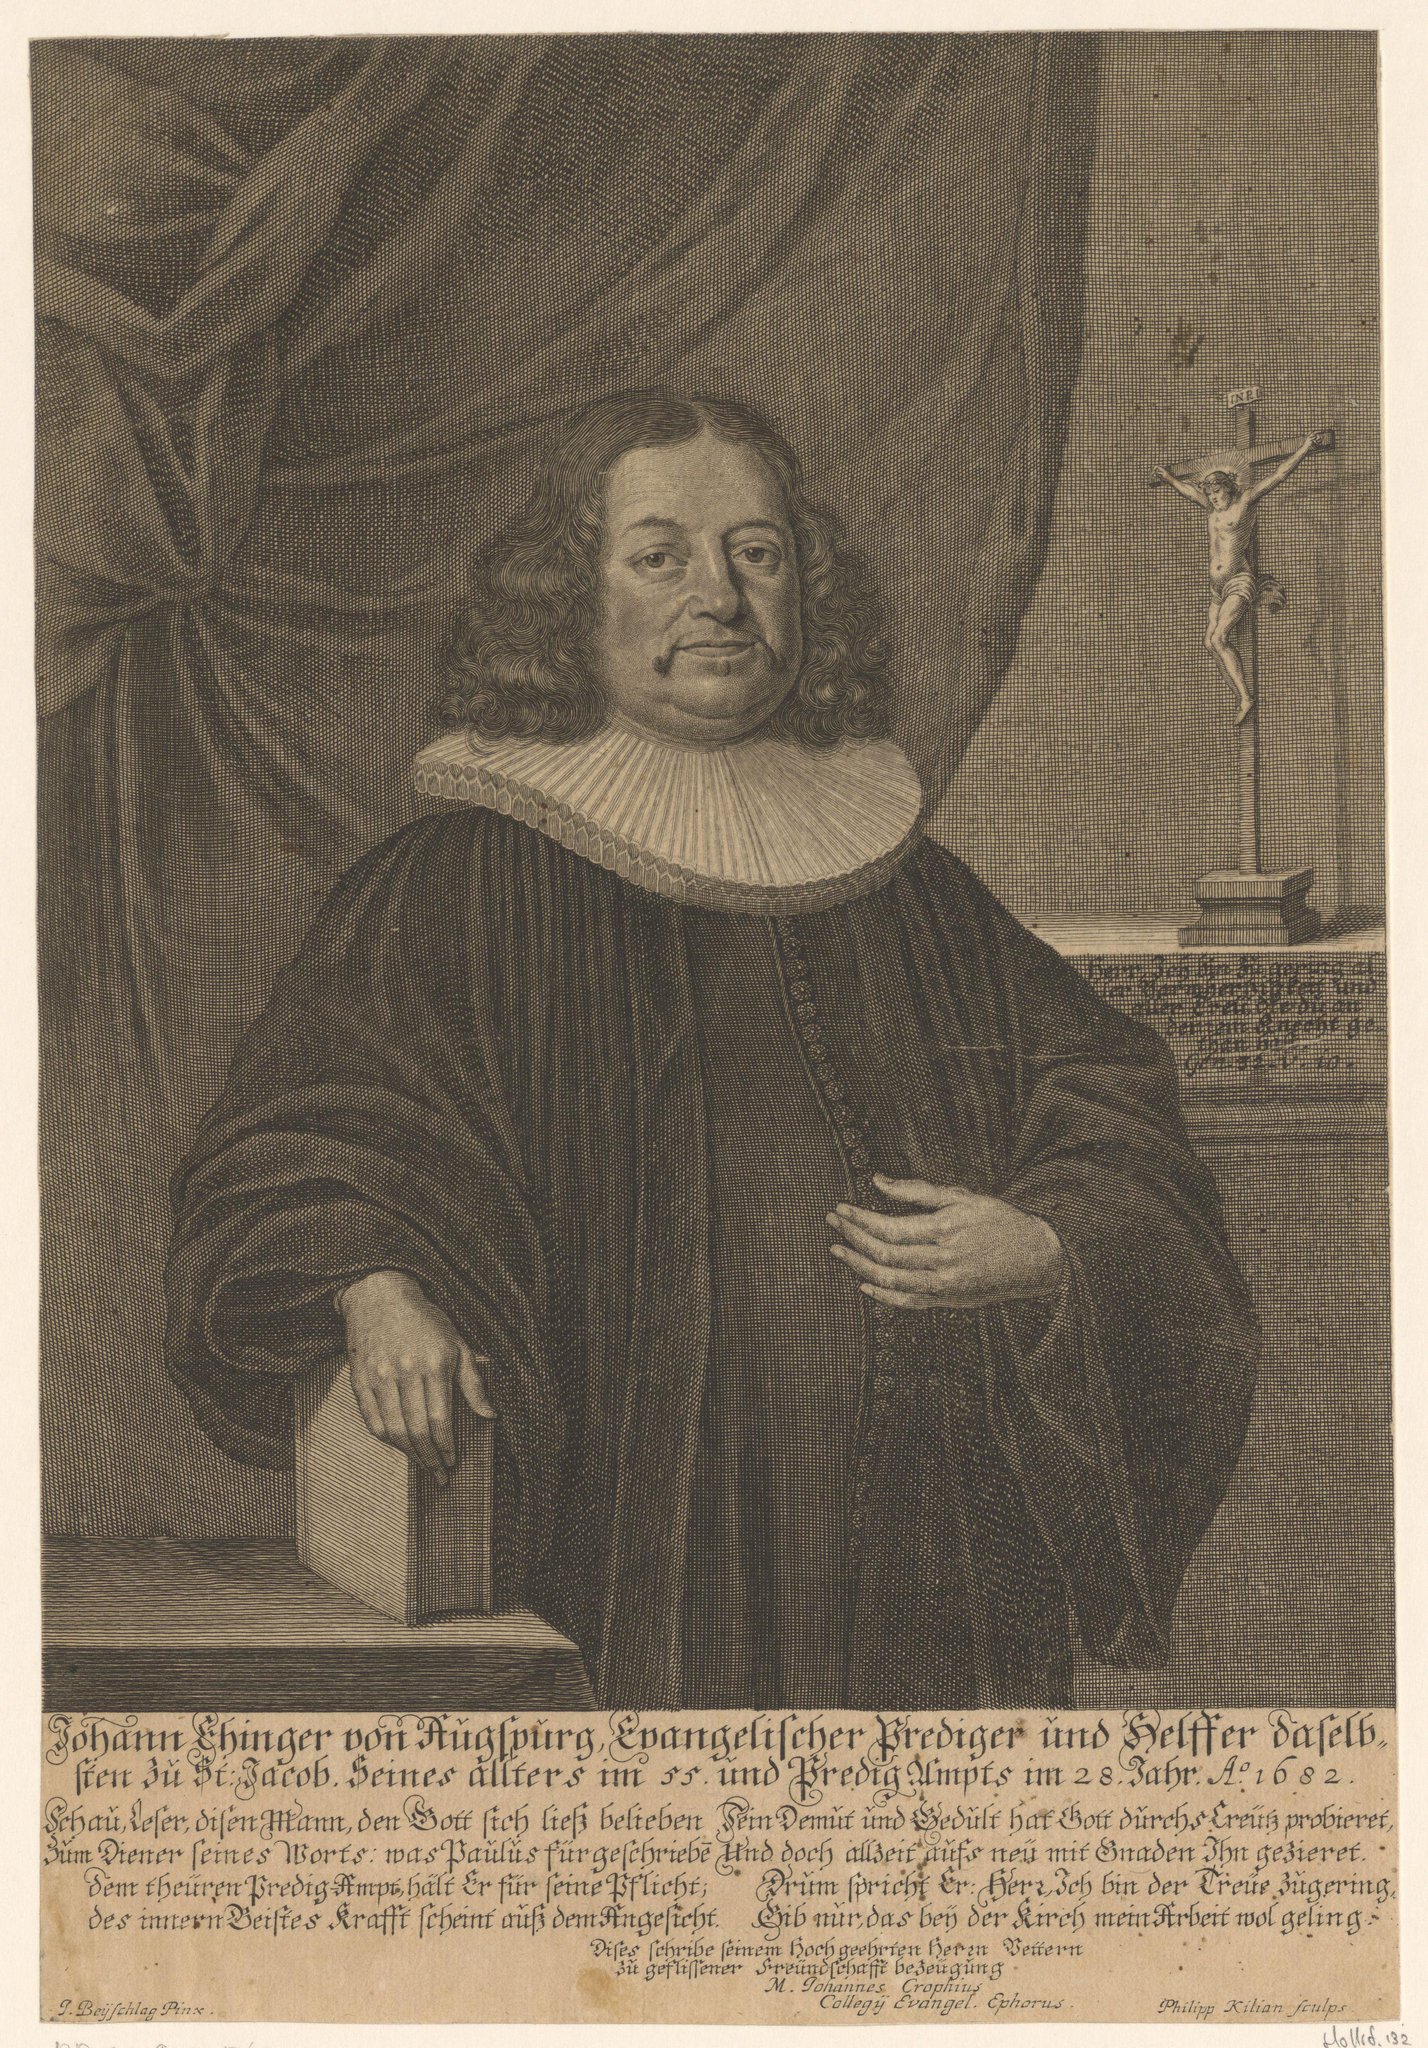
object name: print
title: Portret van Johann Ehinger op 55-jarige leeftijd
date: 1682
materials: paper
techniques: engraving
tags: augsburg, theologian, historical persons, crucifix ~ personal devotion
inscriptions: collector's mark: Lugt 2228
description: Een Bijbeltekst uit Gen. 32:10 in het Latijn op de sokkel onder het crucifix en tekst in het Duits in de ondermarge.